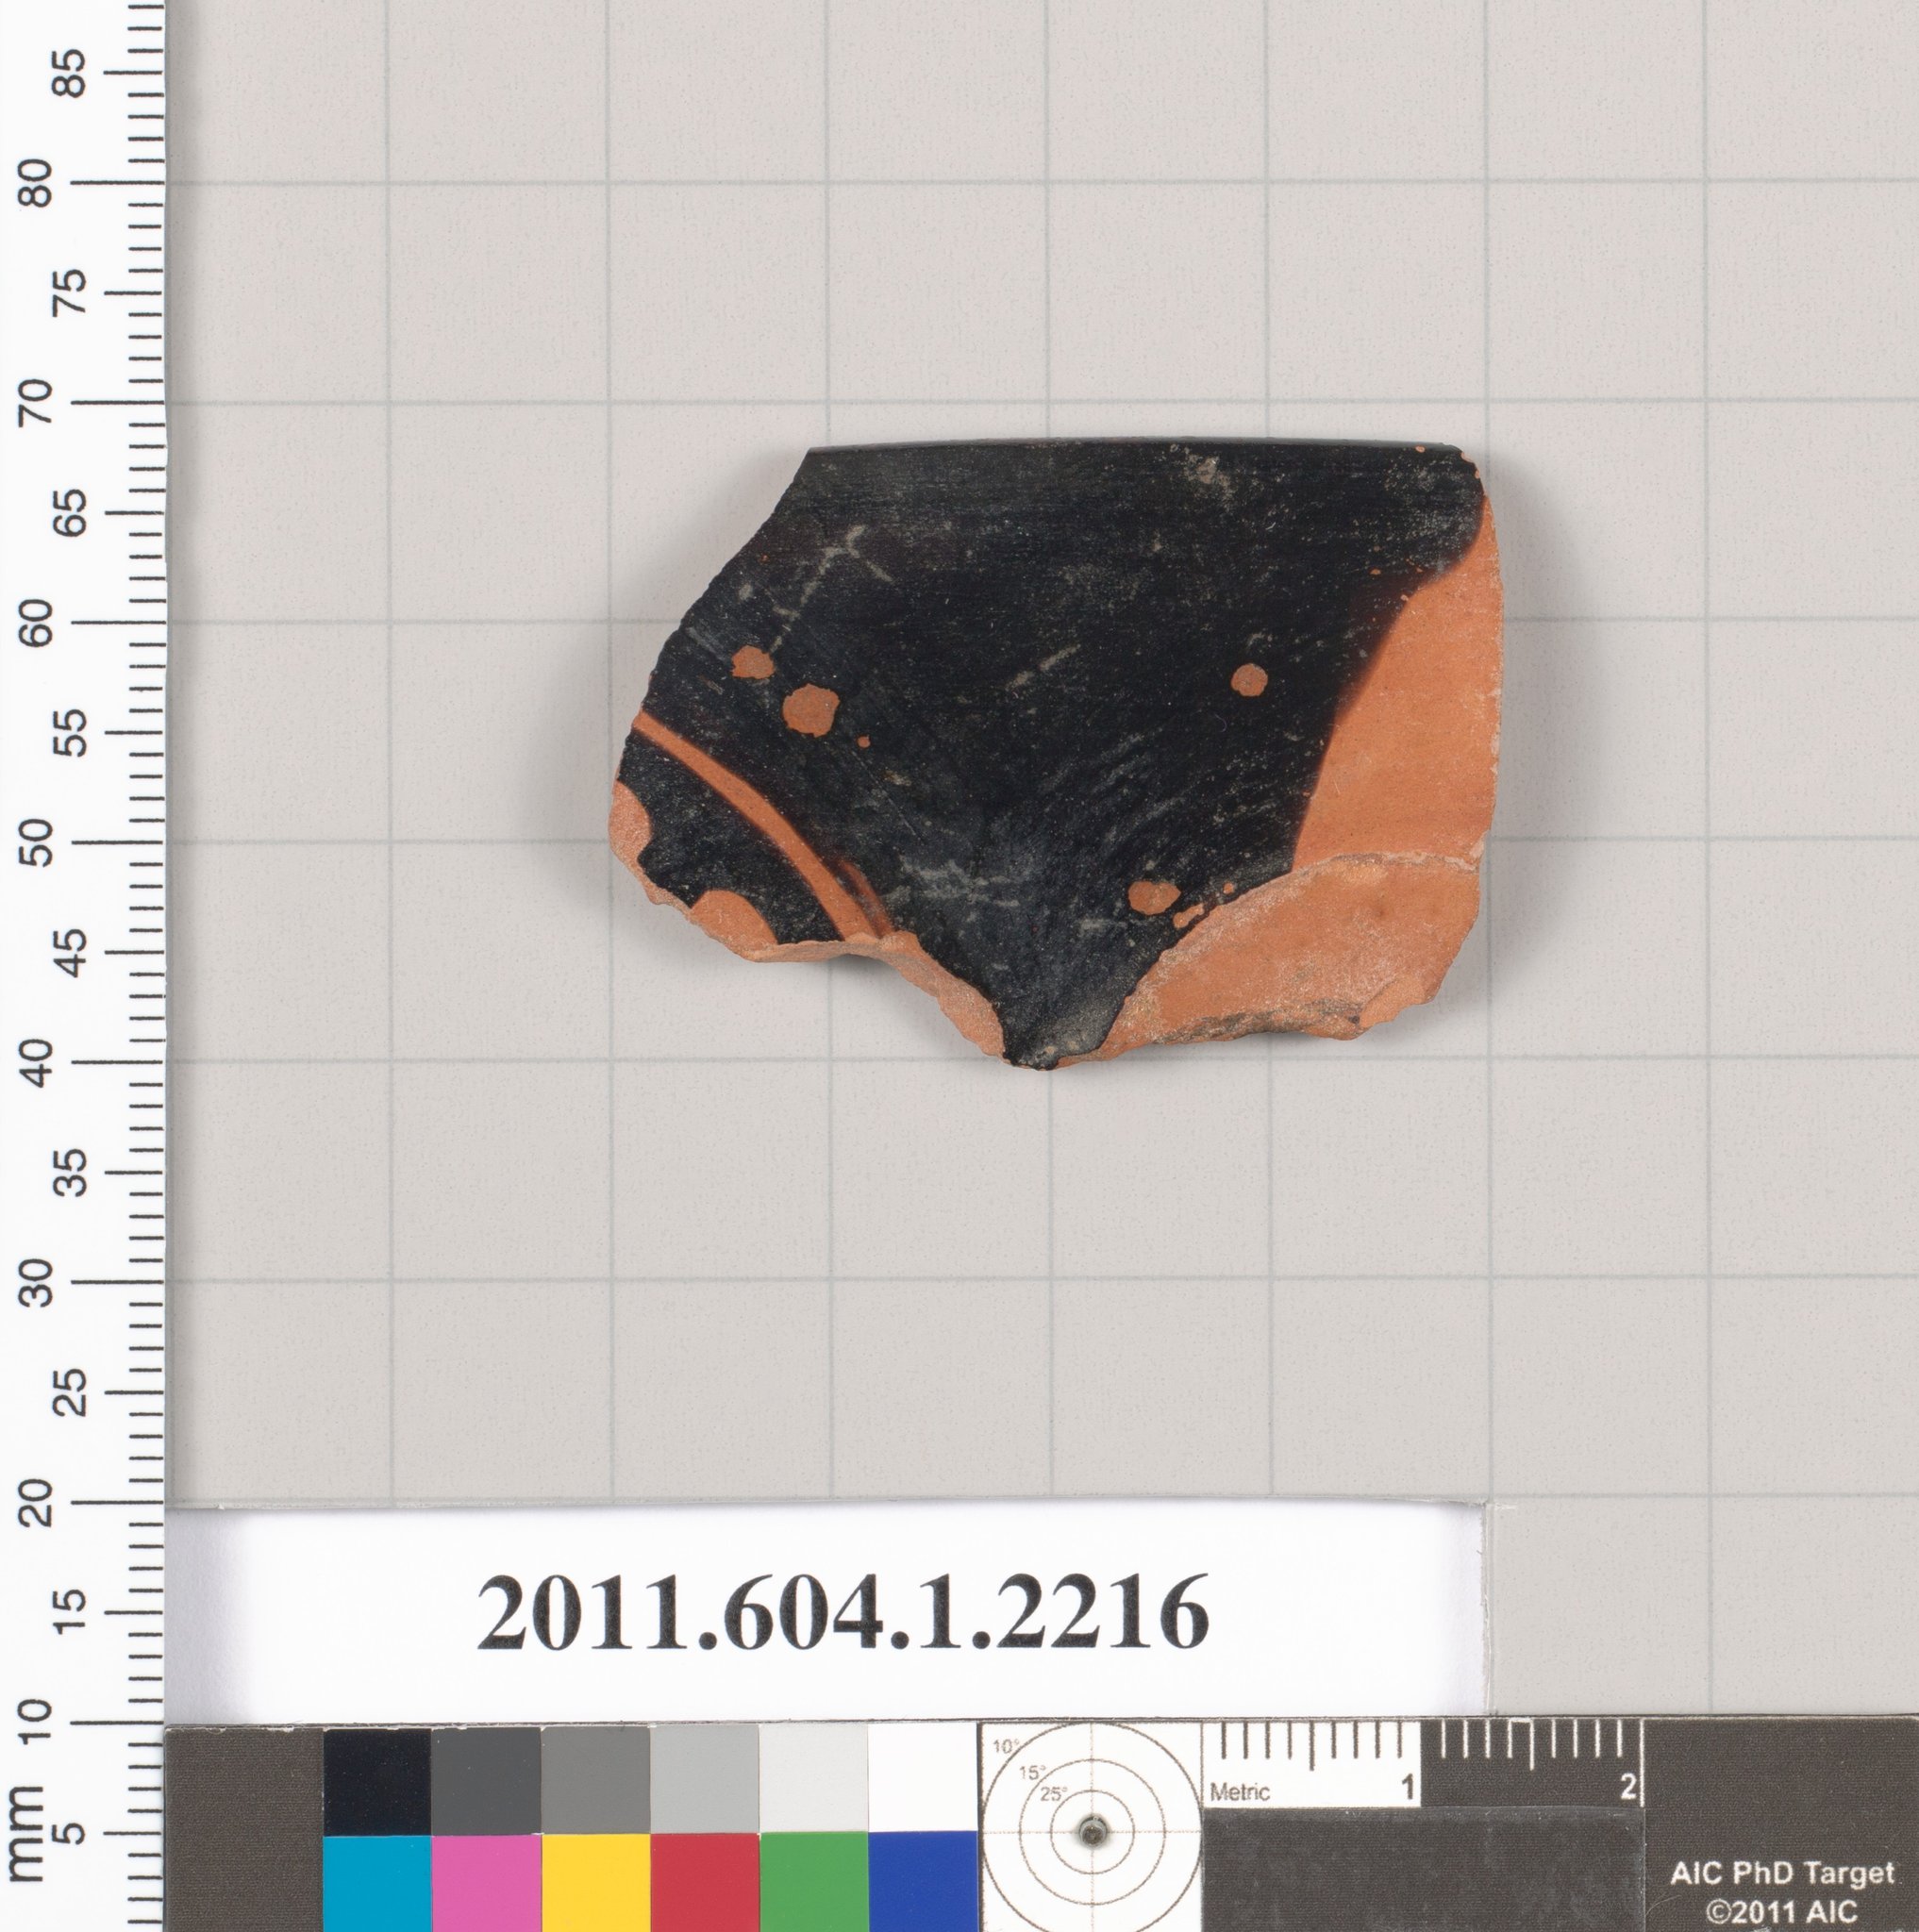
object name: kylix fragment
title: Terracotta rim fragment of a kylix (drinking cup)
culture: greek, attic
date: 475-451 BCE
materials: terracotta